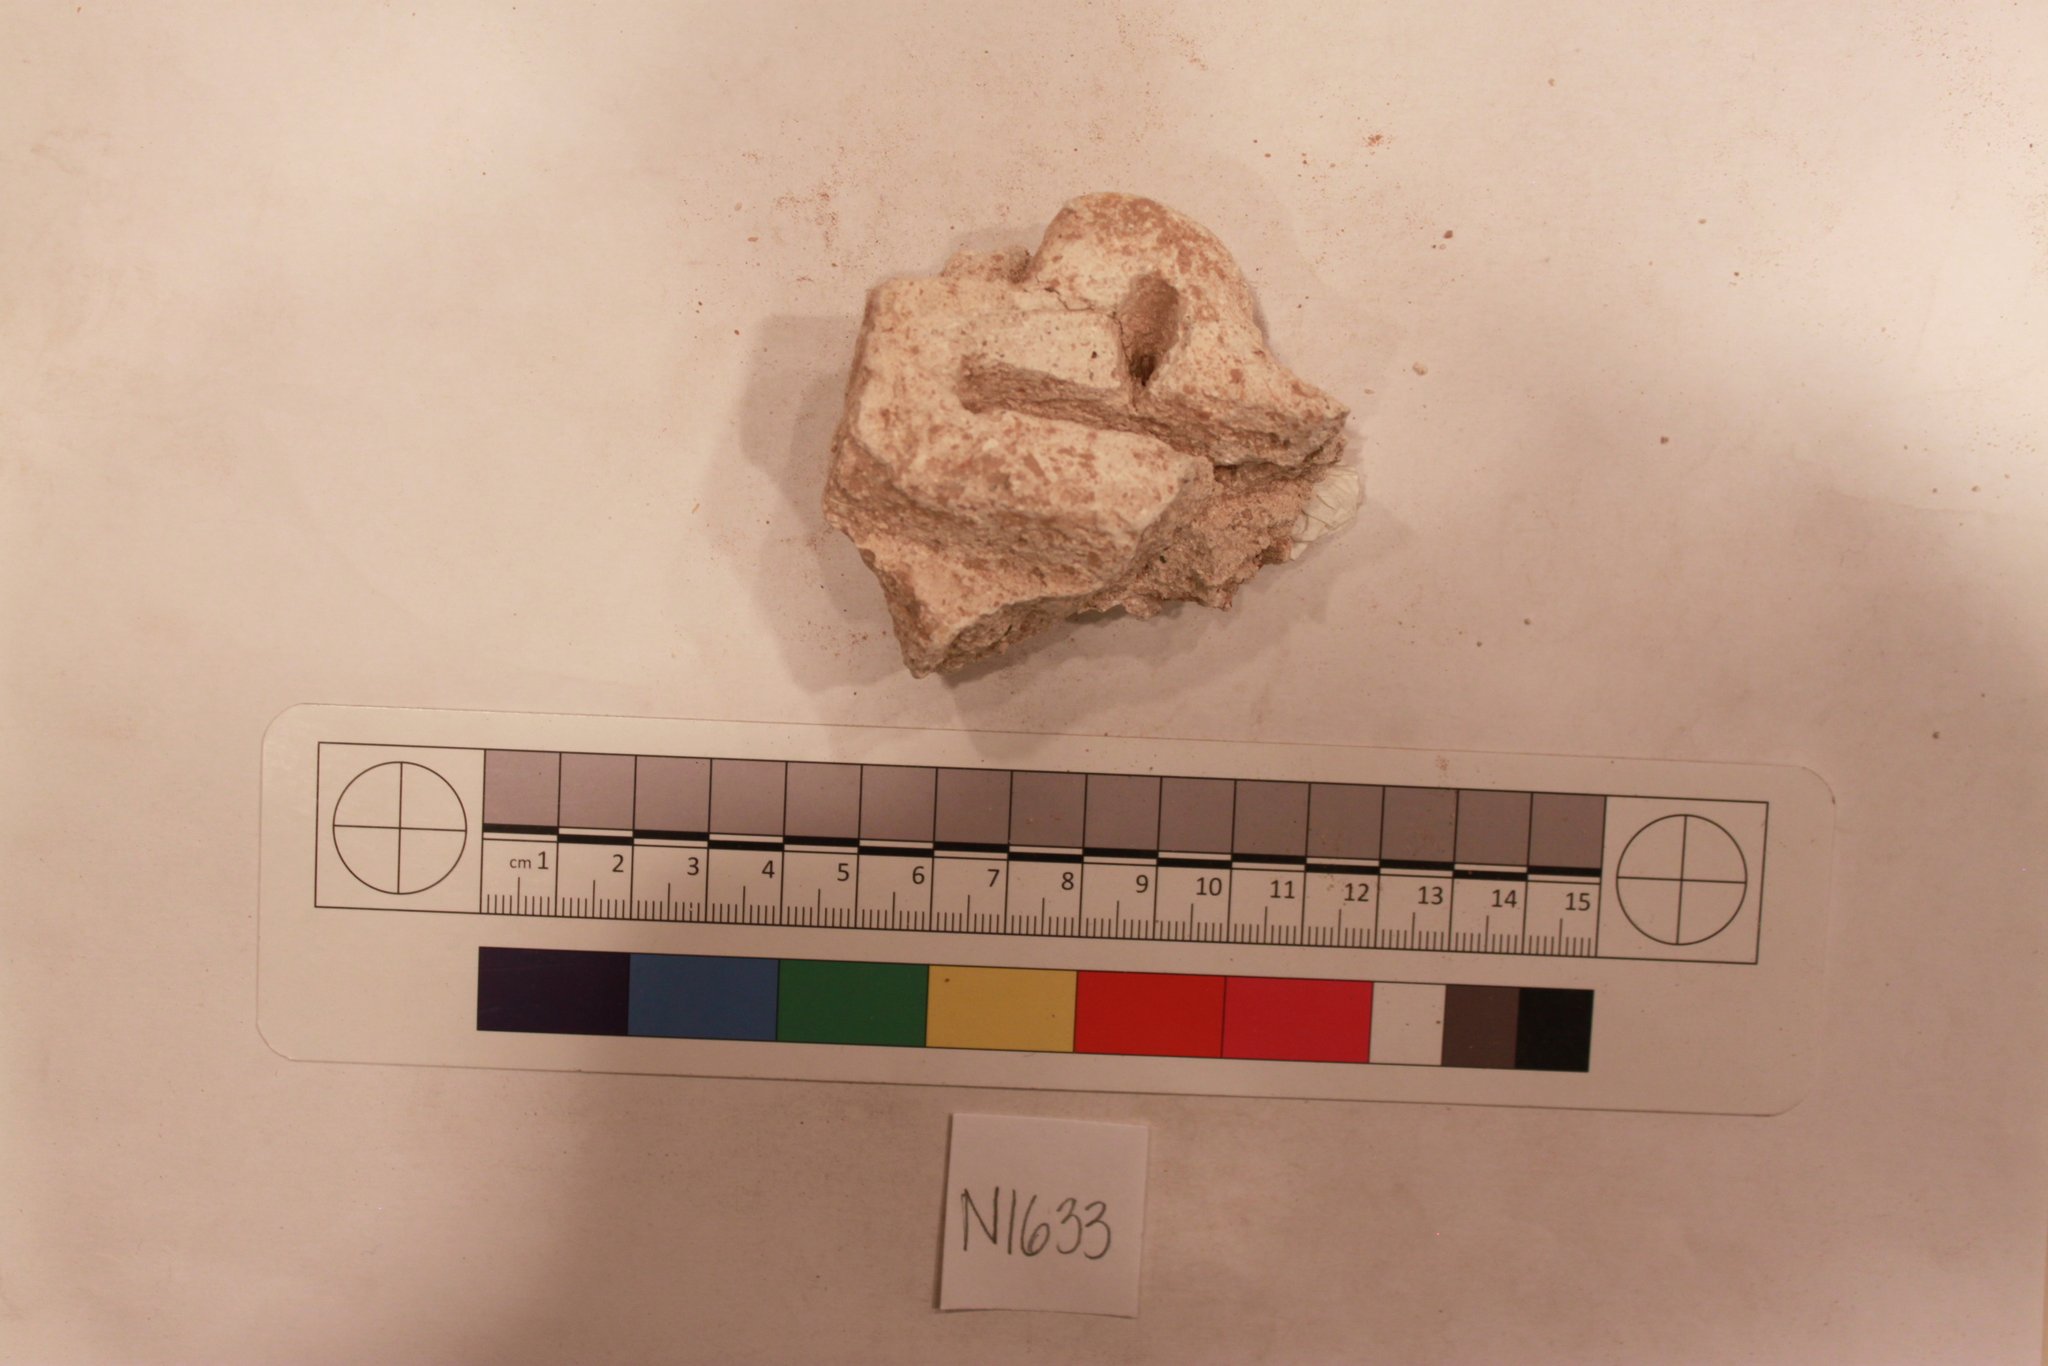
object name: fragment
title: Stucco Fragment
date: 701-1200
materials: plaster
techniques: carving, painting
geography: iran